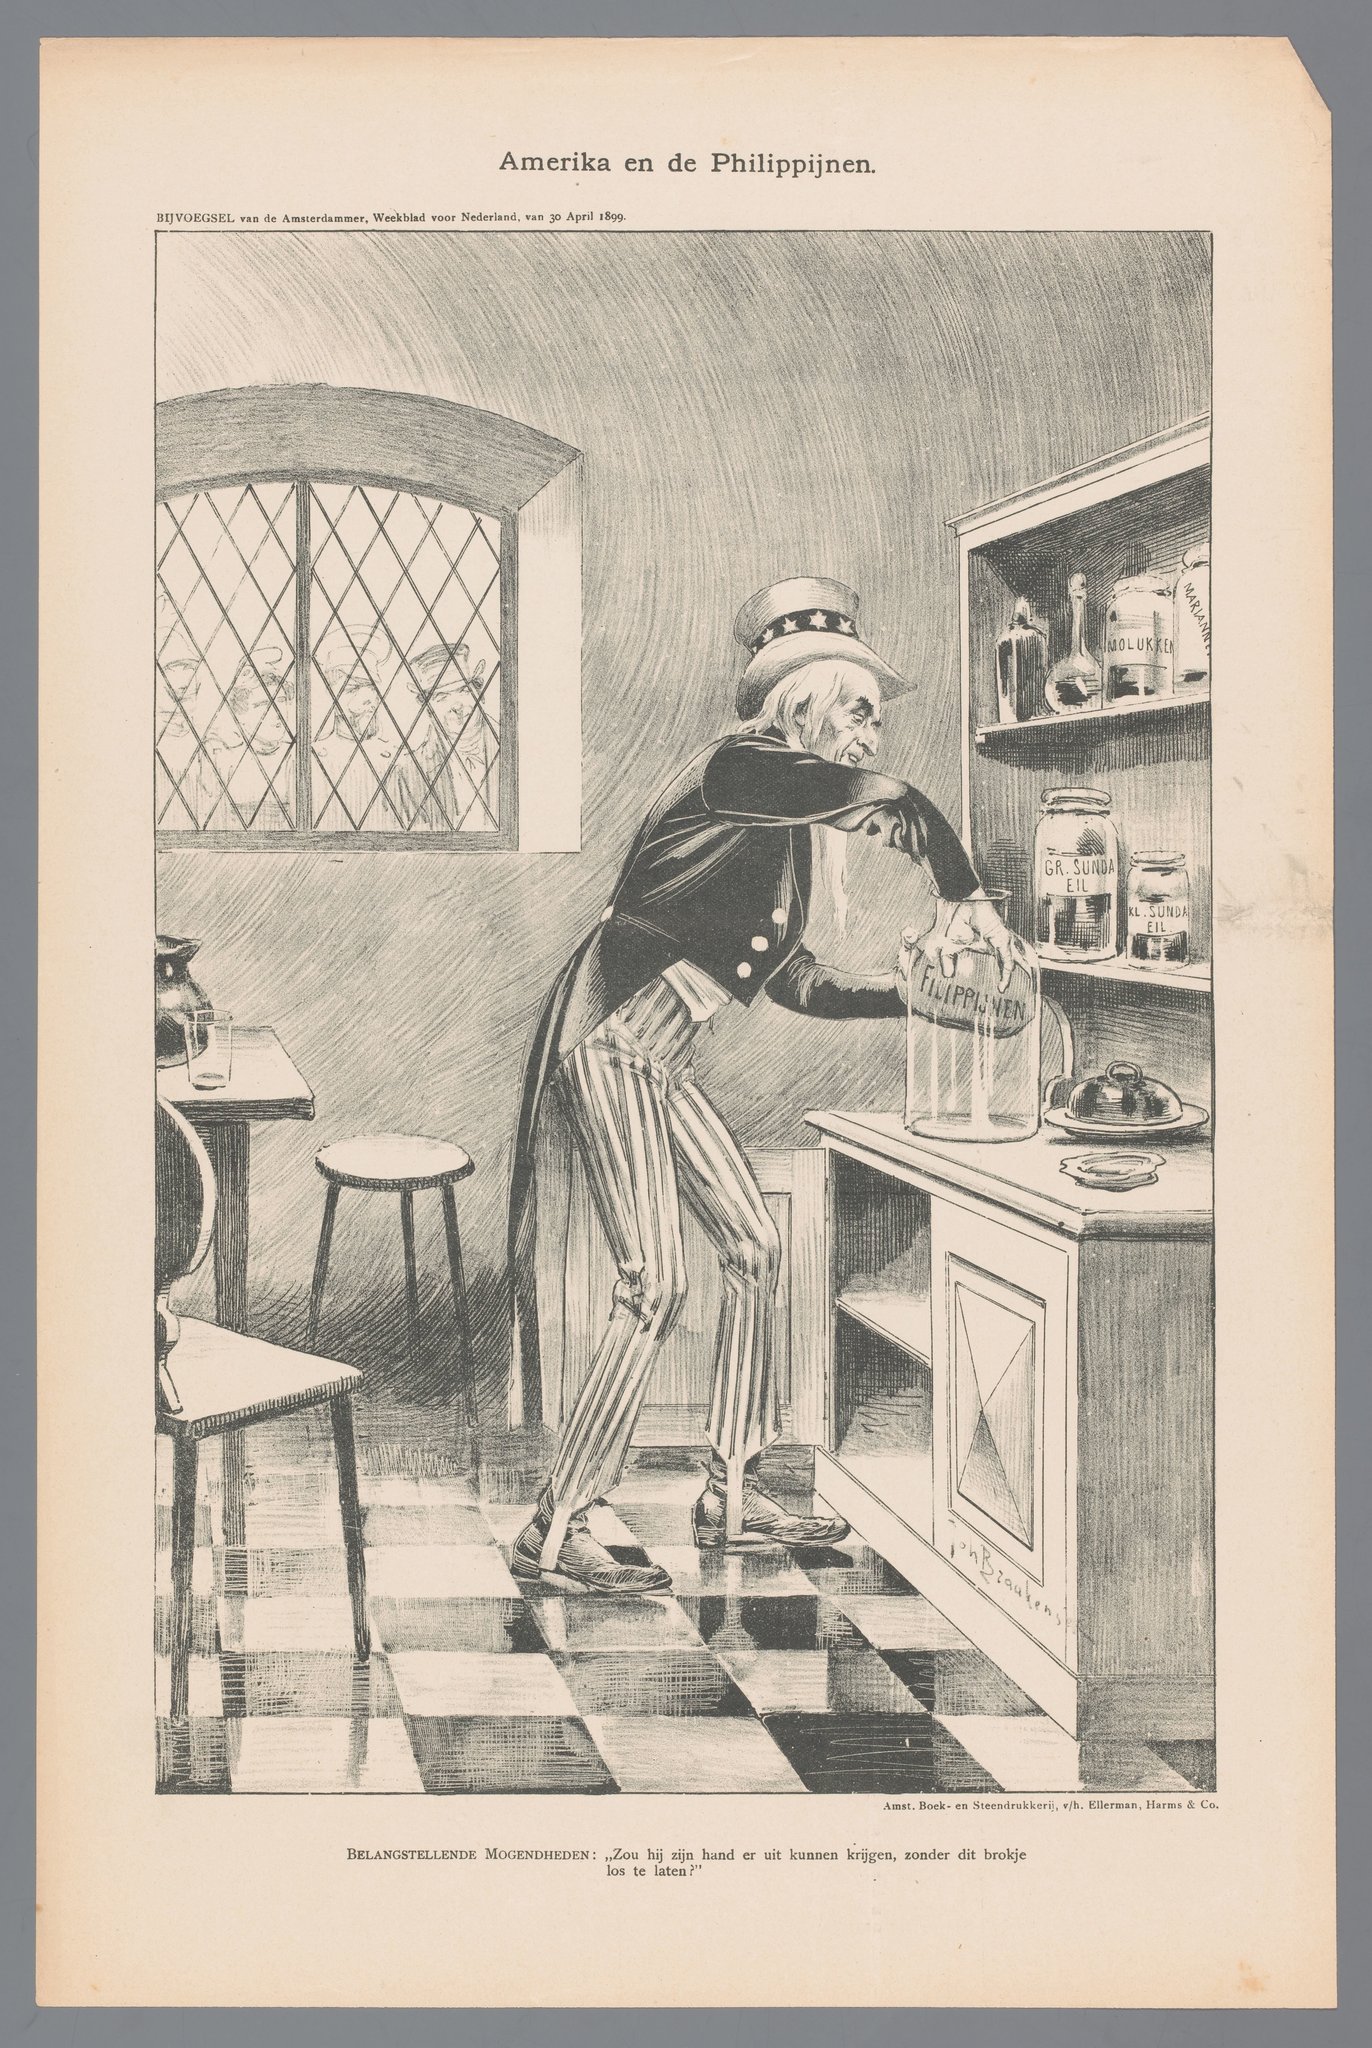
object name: cartoon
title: Amerika en de Philippijnen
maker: johan braakensiek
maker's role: draughtsman, print maker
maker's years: 1858-1940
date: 1899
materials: paper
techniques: lithograph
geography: amsterdam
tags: personifications of countries, nations, states, districts, etc., political caricatures and satires, united states of america, philippines, philippine–american war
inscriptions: date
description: Prent uit het bijvoegsel van: De Amsterdammer. Weekblad voor Nederland, 30 april 1899.